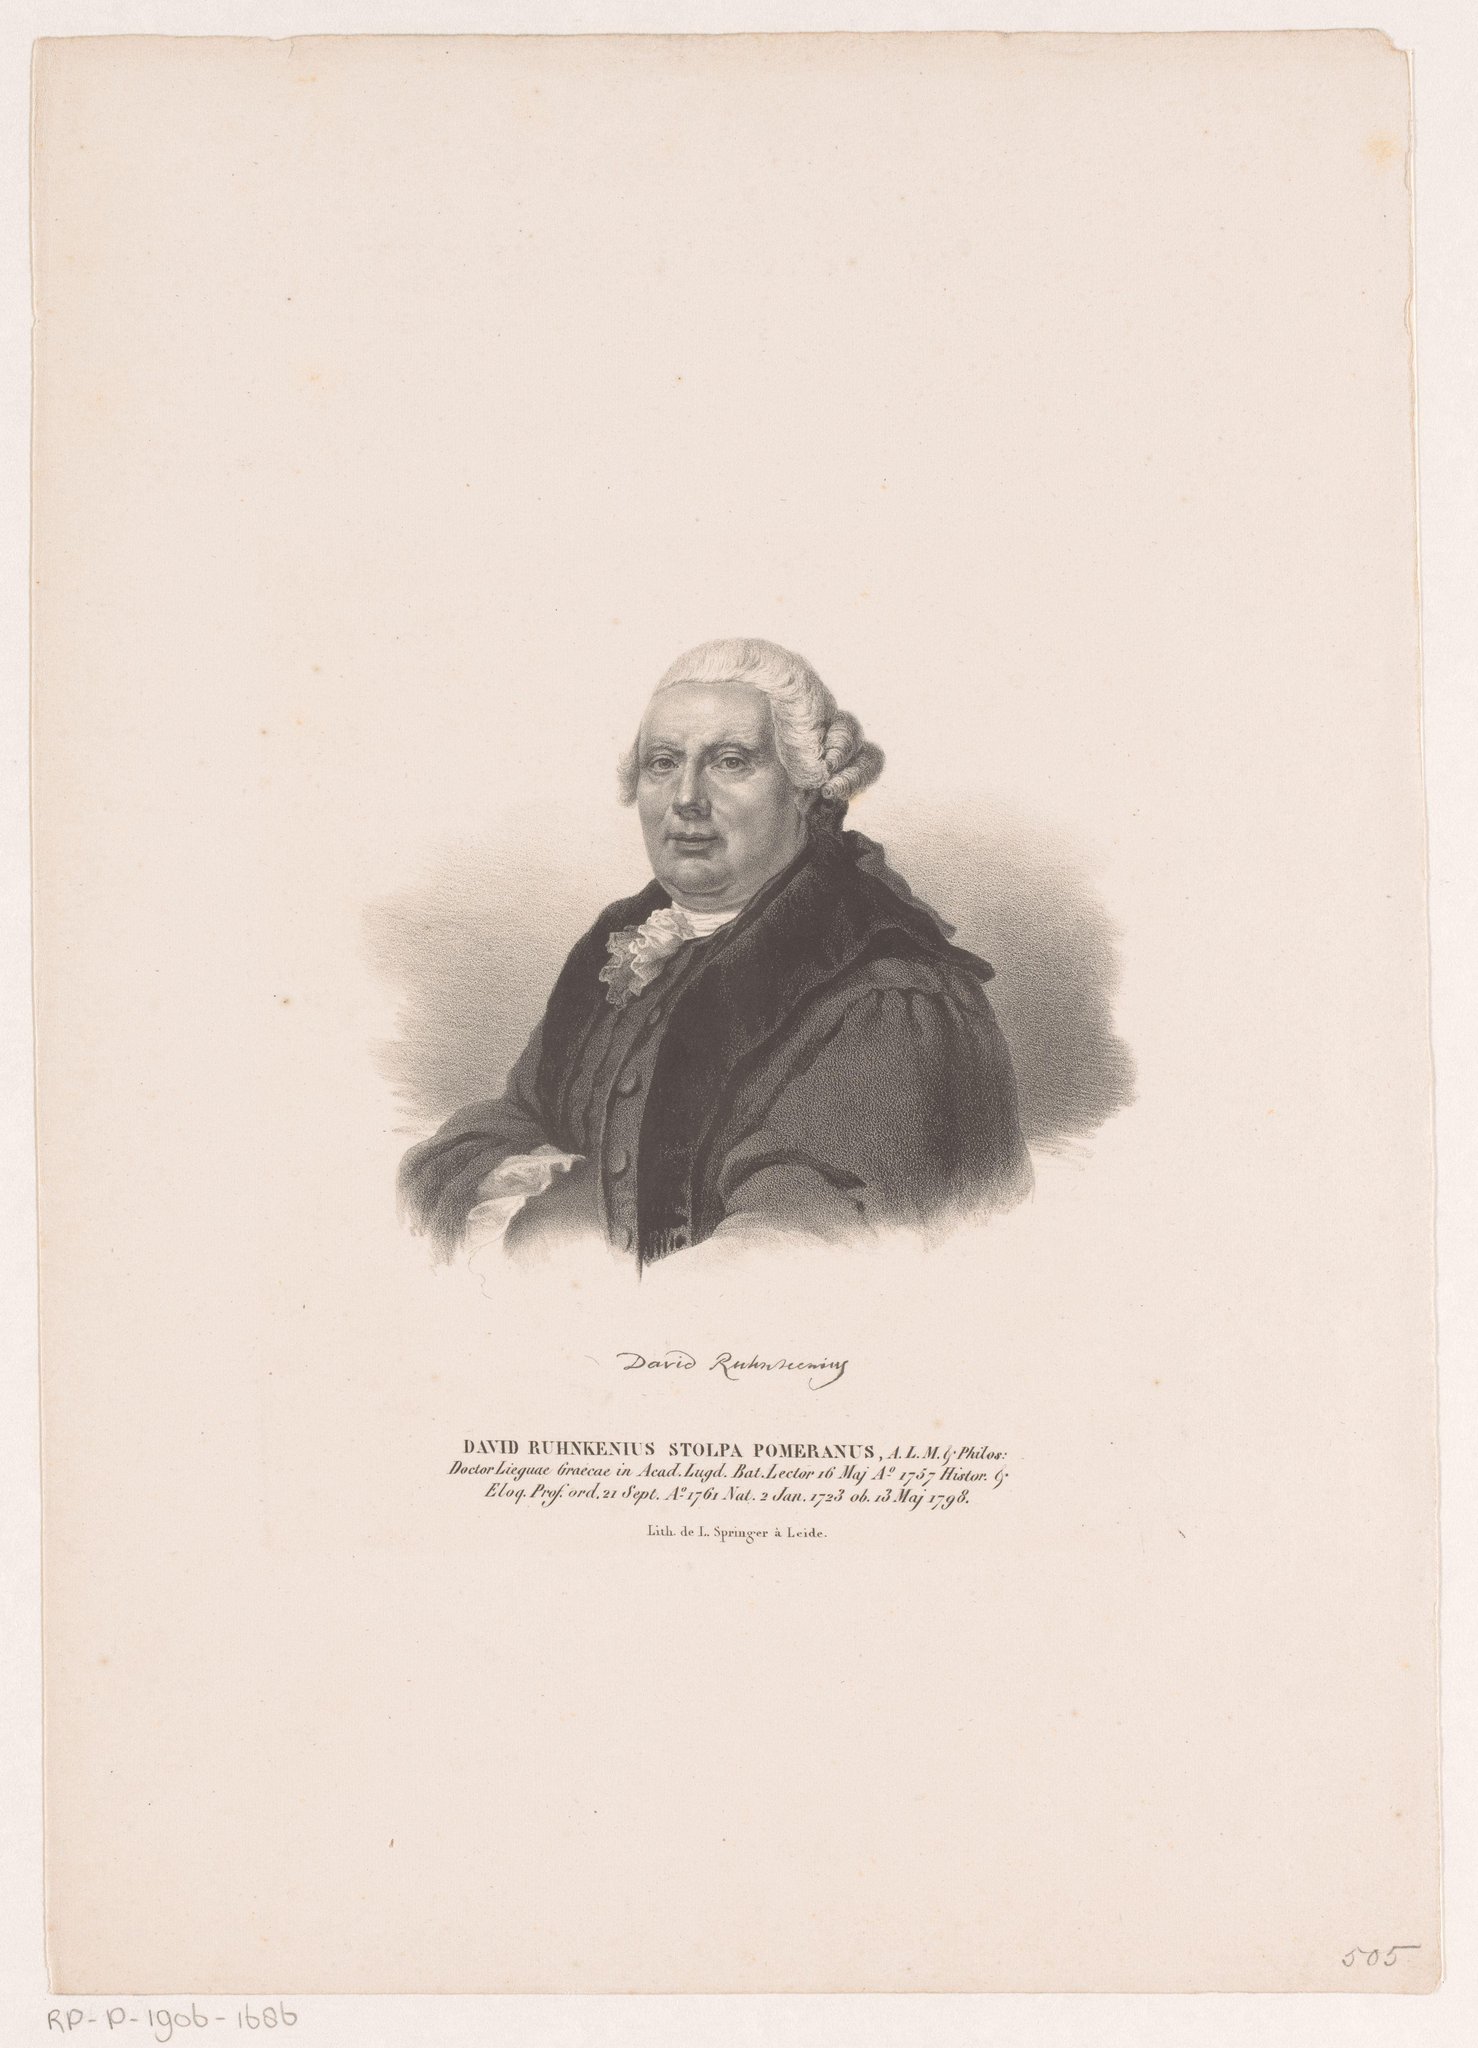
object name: print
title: David Ruhnkenius Stolpa Pomeranus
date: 1809-1853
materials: paper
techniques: lithograph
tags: leiden, historical persons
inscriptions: collector's mark: Lugt 2228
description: Onder het portret de signatuur en biografische gegevens van de geportretteerde.